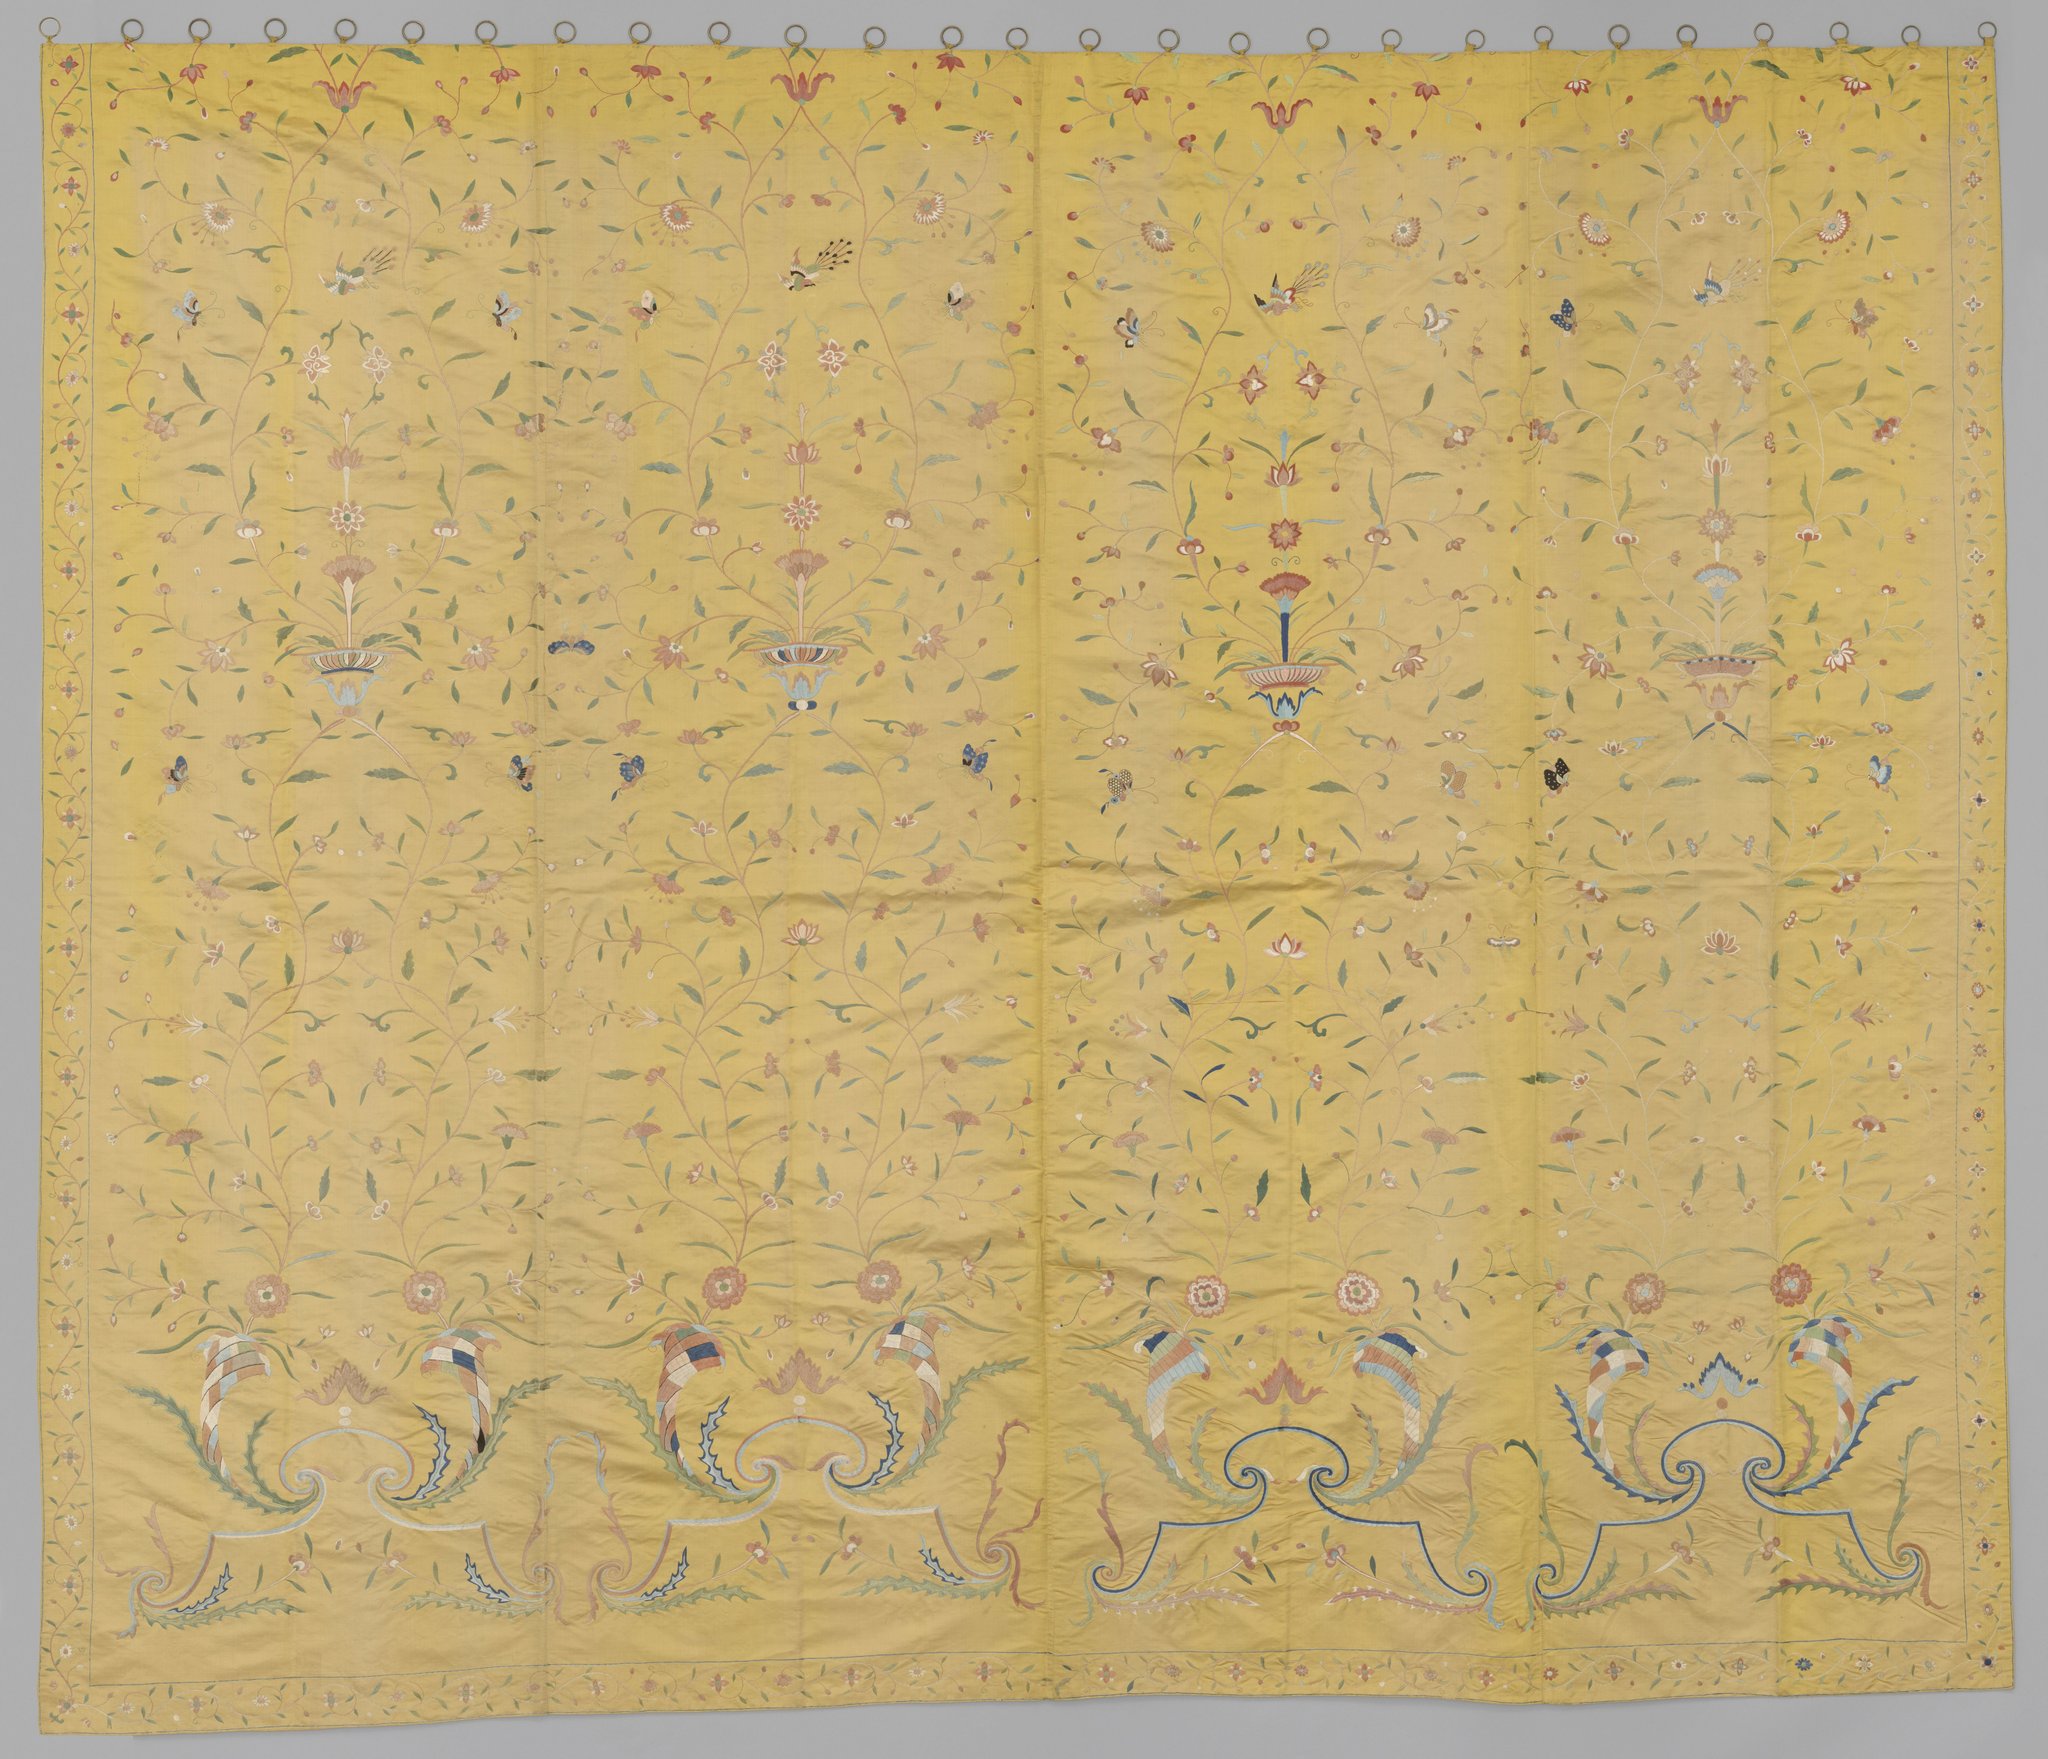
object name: bed covering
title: Gordijn, geel, geborduurd met vazen, bloemranken, hoorns van overvloed, pauwen en vlinders.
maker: Anonymous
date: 1720-1740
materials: silk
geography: guangdong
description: Geel zijden gordijn van een bedgarnituur geborduurd met vazen, bloemranken, hoorns van overvloed, pauwen en vlinders in veelkleurige zijde, gevoerd met gele zijde. Bestemd voor de rechterzijkant.